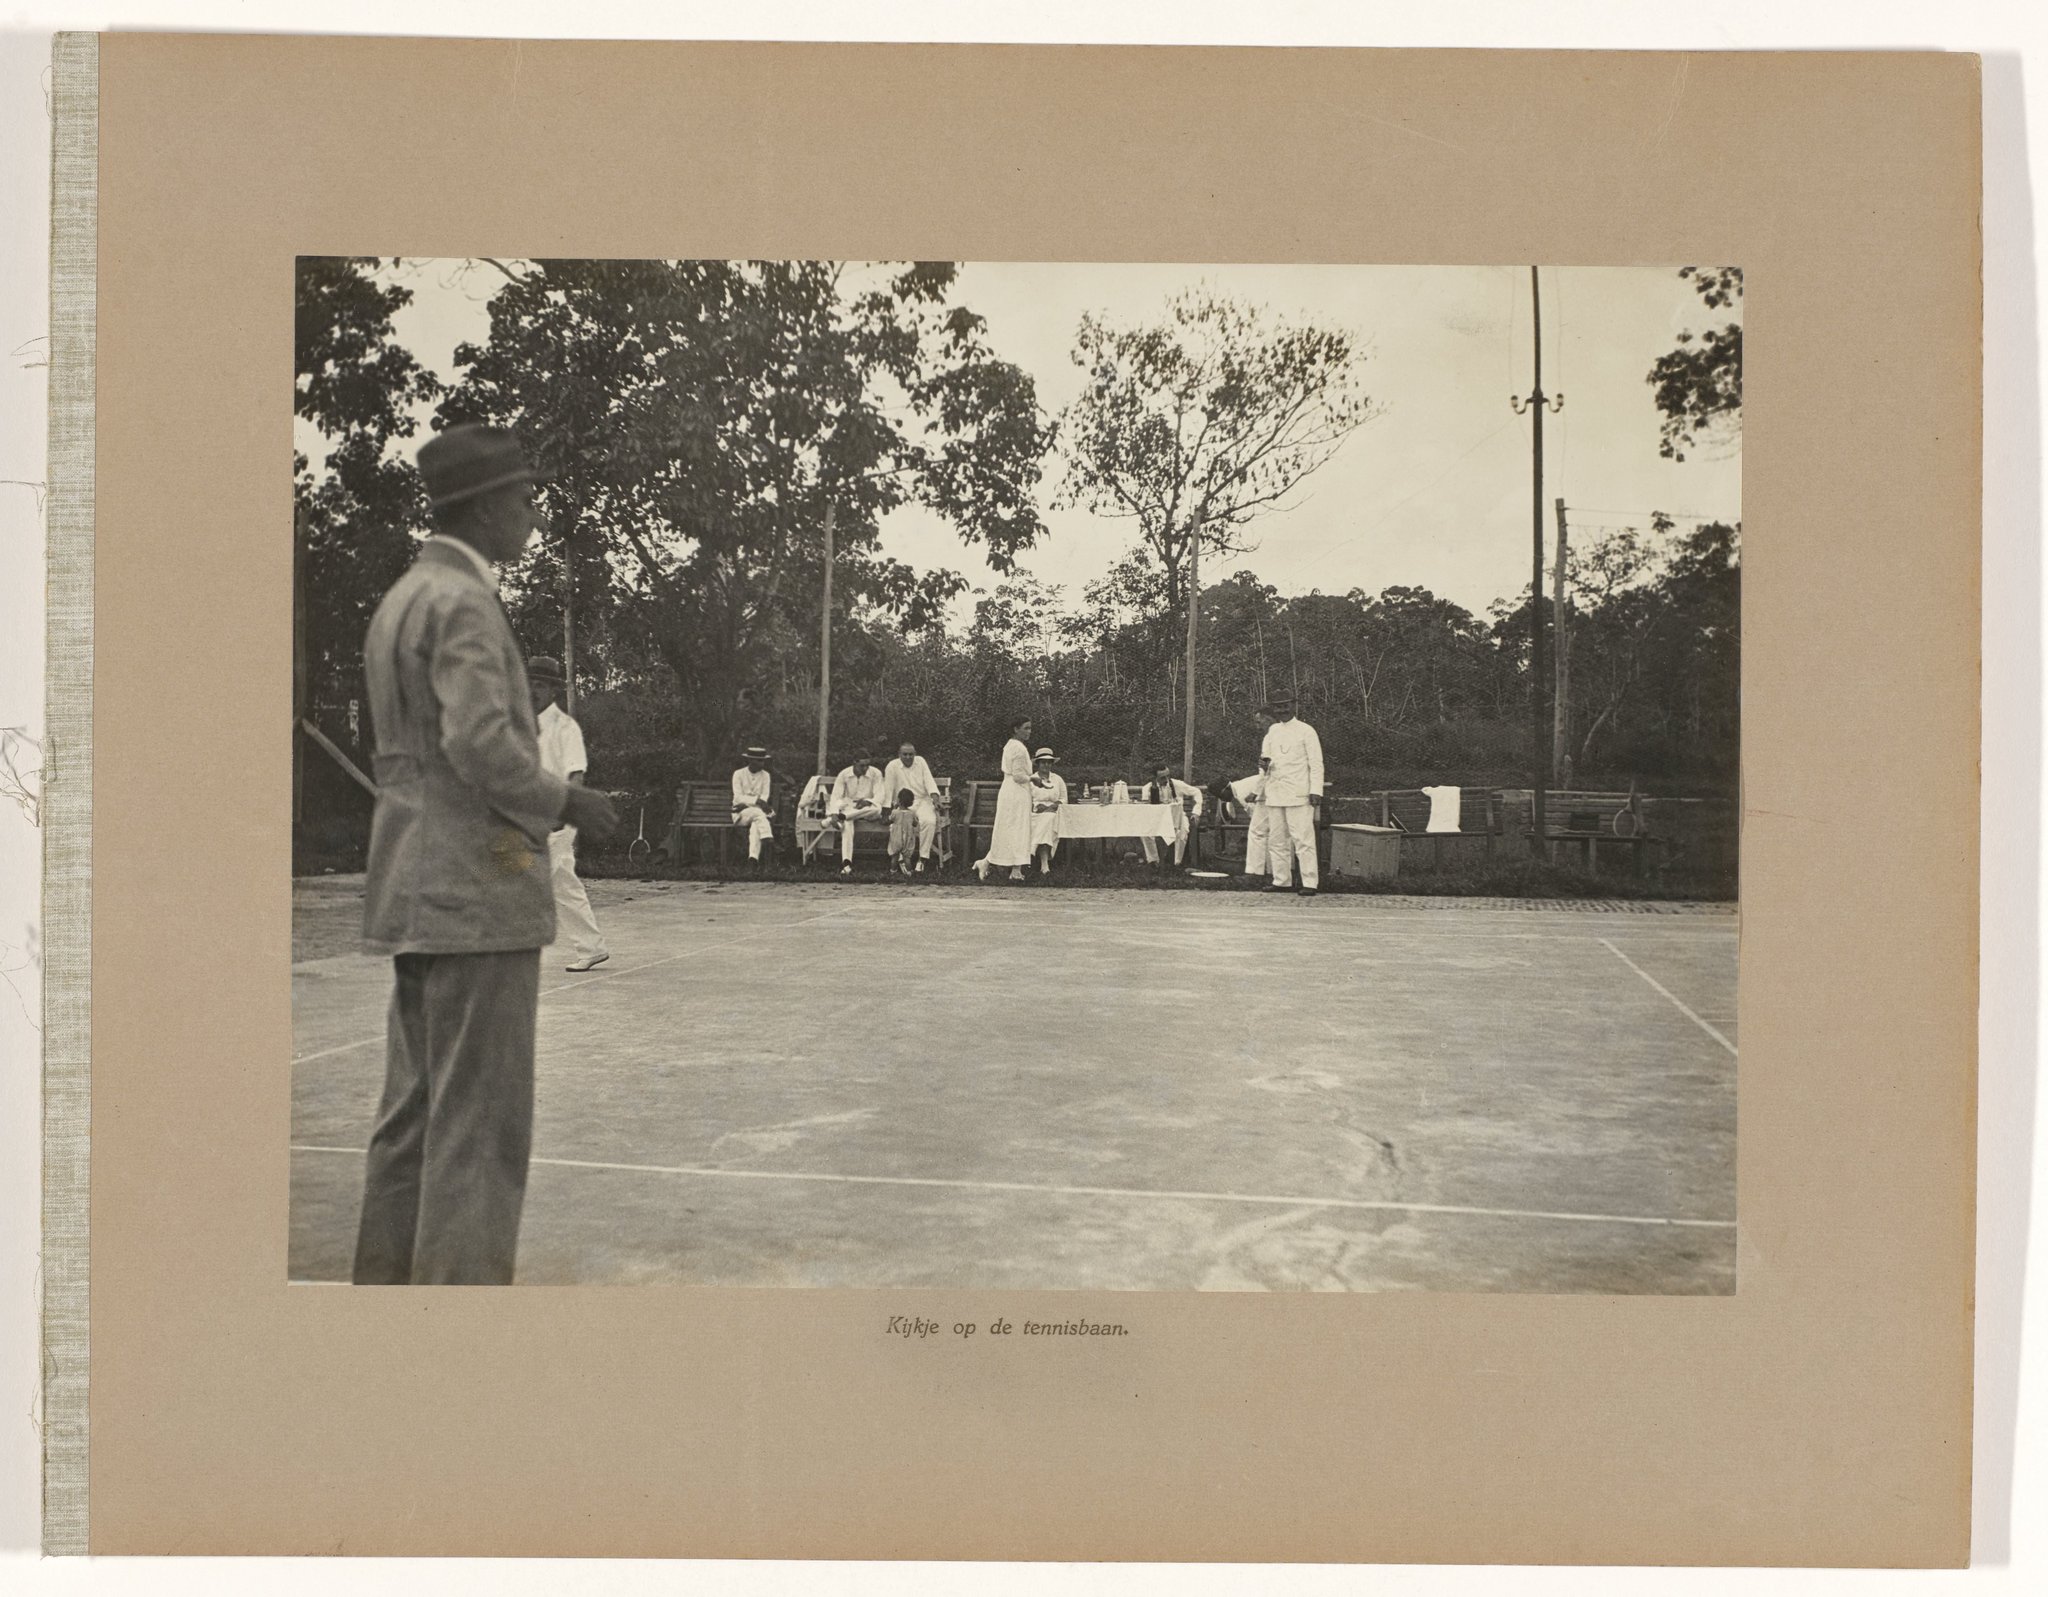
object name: photograph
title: Kijkje op de tennisbaan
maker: Anonymous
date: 1921-1922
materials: photographic support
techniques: gelatin silver print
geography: bukit asam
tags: colonial system, tennis, lawn-tennis, sumatra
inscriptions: inscription: ‘Kijkje op de tennisbaan.’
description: Spelers en toeschouwers op en bij de tennisbaan voor het personeel van de mijn. Onderdeel van het losbladige fotoalbum aangeboden door het personeel van de Boekit-Asam Steenkolenmijnen op Sumatra aan de scheidende Ingenieur-Directeur H. Tromp op 7 januari 1922.